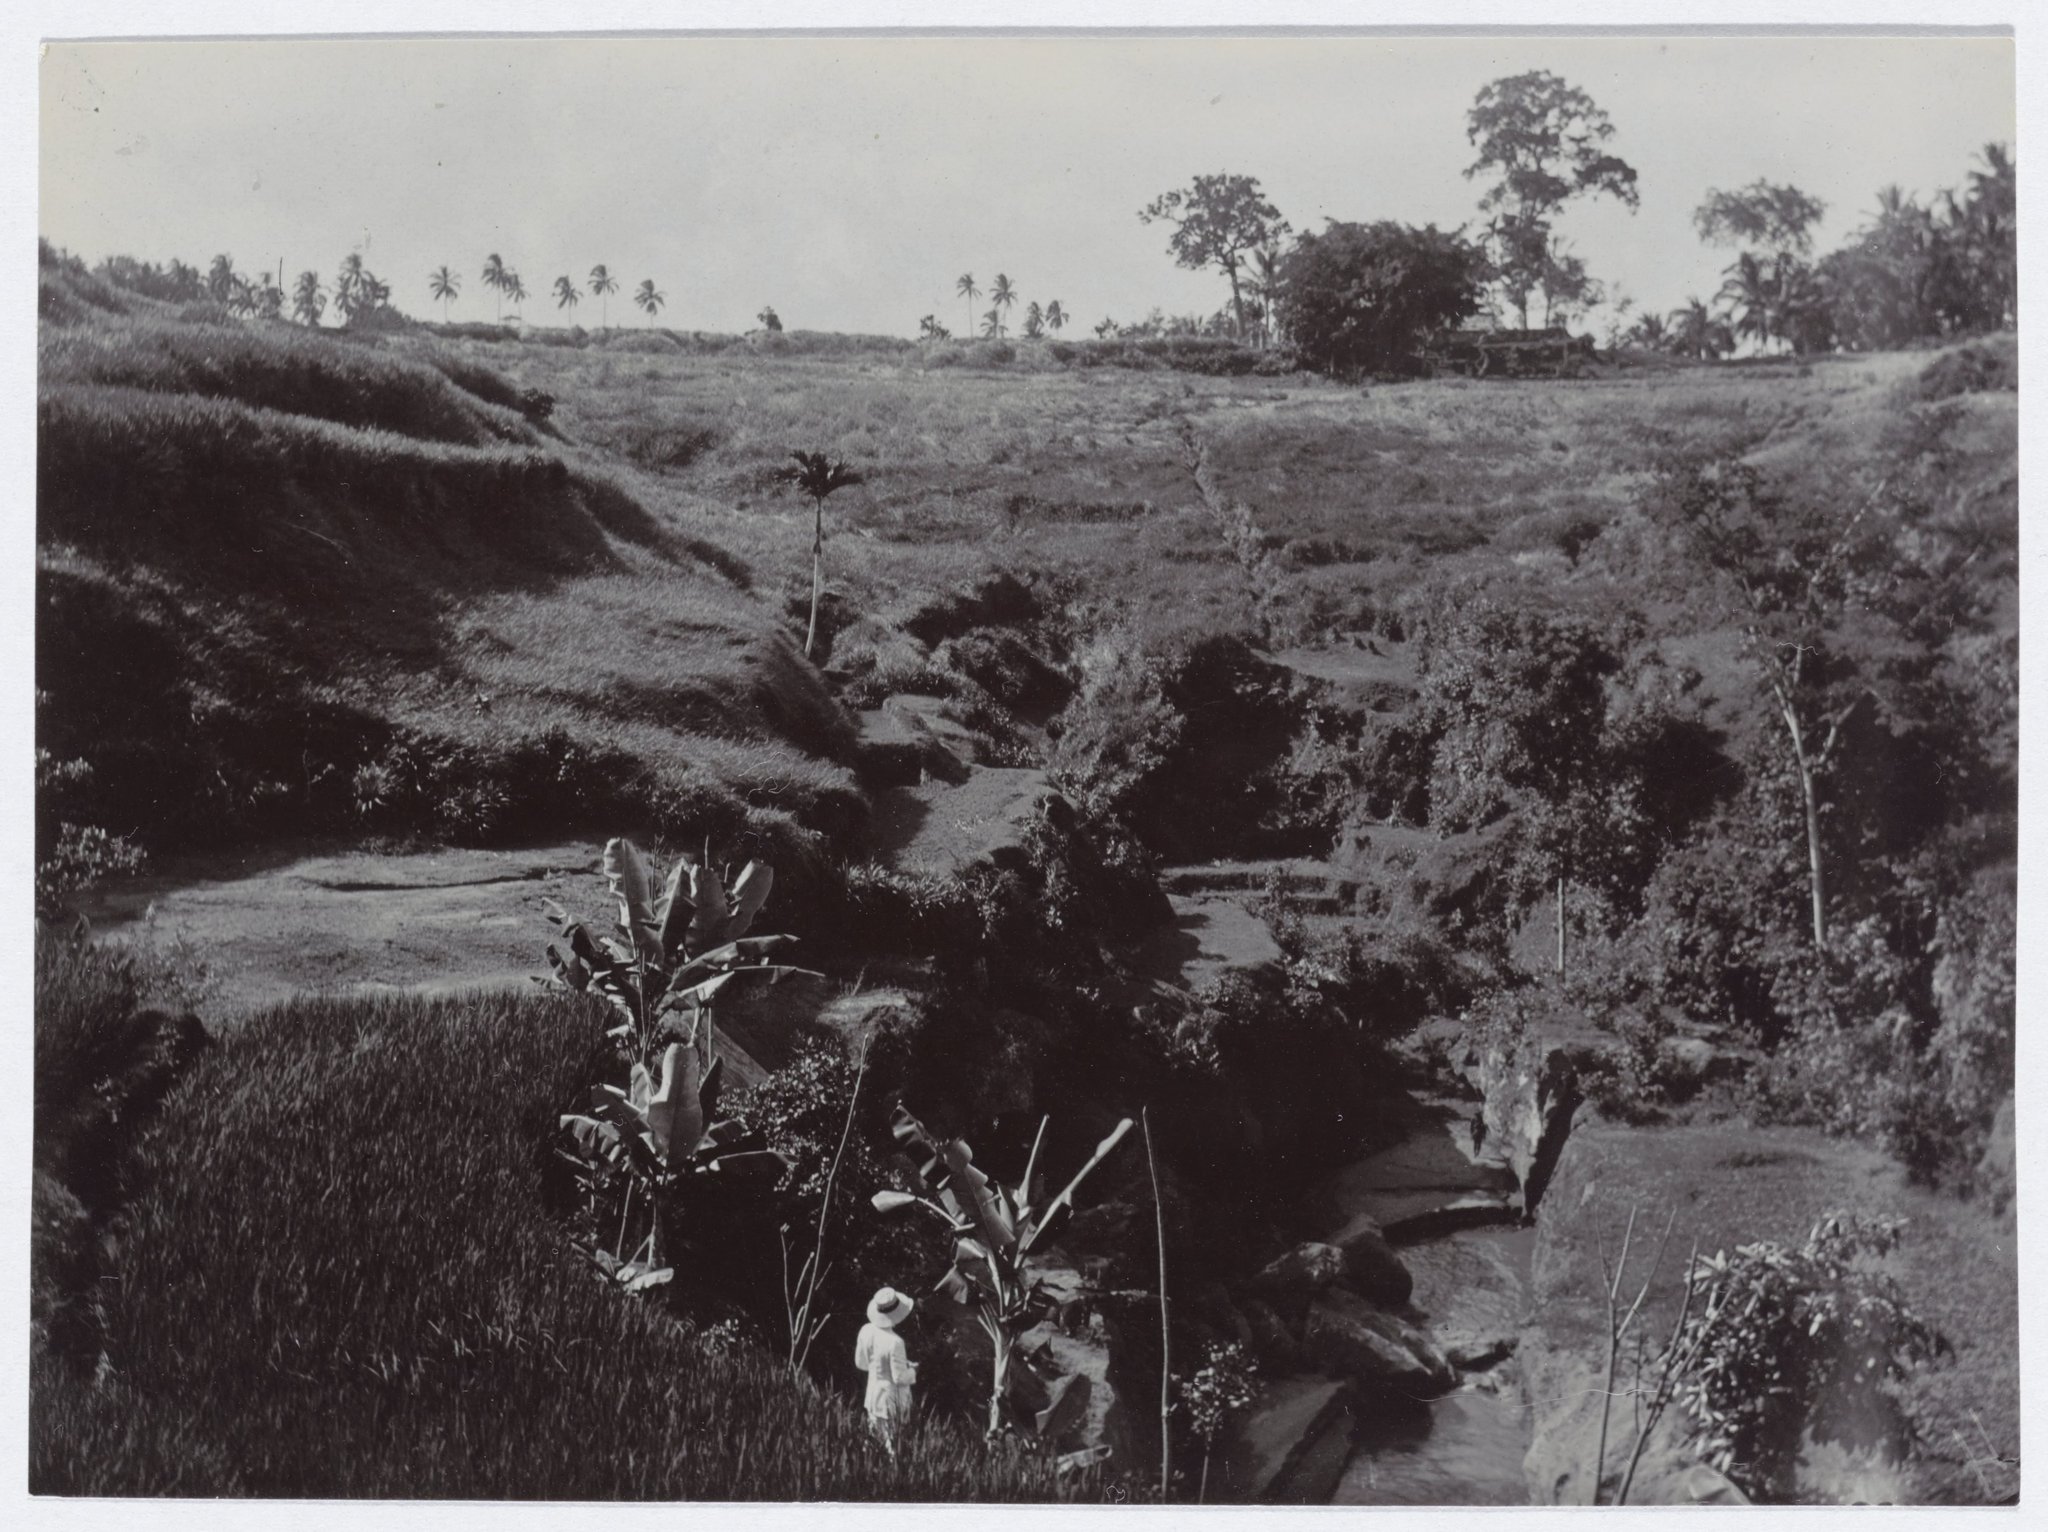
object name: photograph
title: 9. Zuid-Bali.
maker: johanna hermina marmelstein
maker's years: 1897-1990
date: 1900-1915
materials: paper, photographic support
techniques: albumen print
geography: jakarta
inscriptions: annotation: ‘9. Zuid-Bali. Aarden dam te Bandoeng bij Gianjar door Baliërs gebouwd ong 225 jaren geleden. Hoogte 39.60 mr, lengte 120 mer. Tot ong. 25 jaren de grootste aarden dam (zonder stenen als kern) van de wereld. Een meesterwerk in zijn soort.’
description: Een dam gemaakt van aarde nabij Bandung. De dam is opgebouwd uit terrassen. Op de achtergrond staan palmbomen.